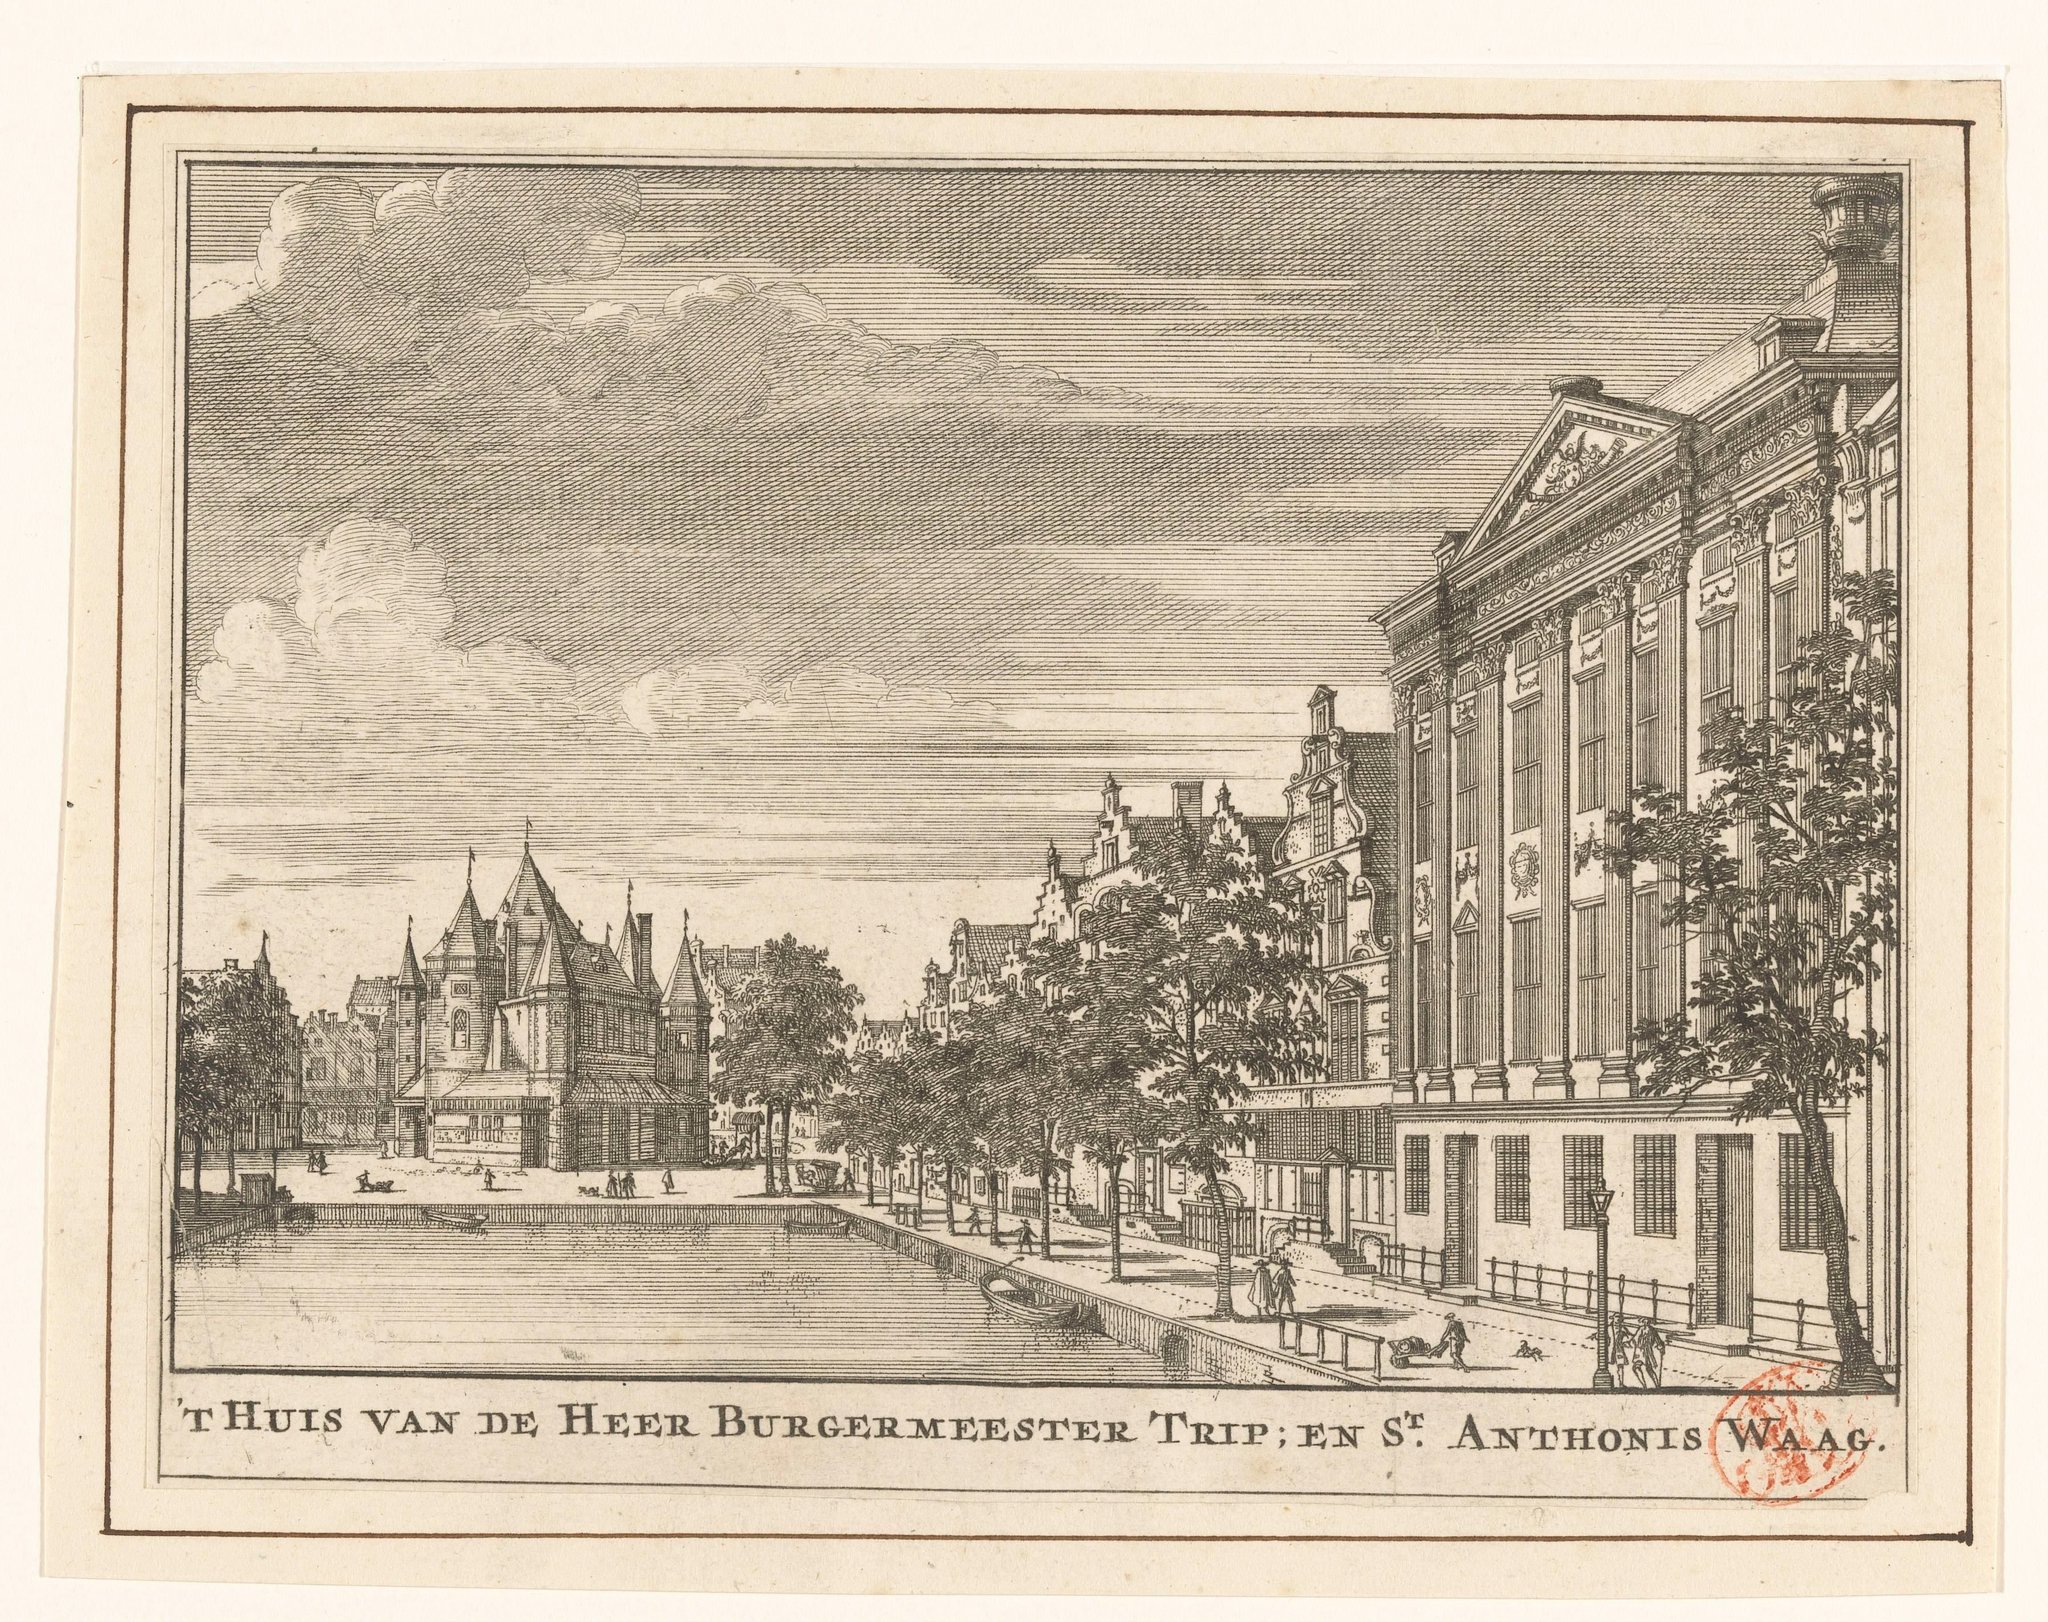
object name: book illustration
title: Gezicht op de Kloveniersburgwal met het Trippenhuis en de Waag op de Nieuwmarkt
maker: Anonymous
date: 1713-1751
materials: paper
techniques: engraving, etching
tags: urban housing, weigh-house, canals, waters (in city) (+ city(-scape) with figures, staffage), street (+ city(-scape) with figures, staffage)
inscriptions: collector's mark: Lugt 195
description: Prent ook gebruikt in: Hoorn, Nicolaas ten. Wegwyzer door Amsterdam, Zynde eene beknopte verhandeling van desselfs eerste opkomst, vergrootingen, en teegenwoordigen staat (…). Amsterdam: Nicolaas ten Hoorn, 1713. En in: Hoorn, Nicolaas ten. Wegwyzer door Amsterdam, Zynde eene beknopte verhandeling van desselfs eerste opkomst, vergrootingen, en teegenwoordigen staat (…). Amsterdam: Nicolaas ten Hoorn, 1726. En in: Hoorn, Nicolaas ten. Wegwyzer, of korte beschryvinge Van de Stadt Amsterdam, Zynde eene beknopte Verhandeling van desselfs eerste opkomst, vergrootingen, en tegenwoordigen staat (…). Amsterdam: erven J. Ratelband & Co, 1737. En in: Hoorn, Nicolaas ten. Wegwyzer of korte beschryvinge der stad Amsterdam. Zynde eene Beknopte Verhandeling van derzelver eerste Opkomst, Vergrootingen en Tegenwoordigen Staat (…). Amsterdam: Pieter Meyer, 1751.